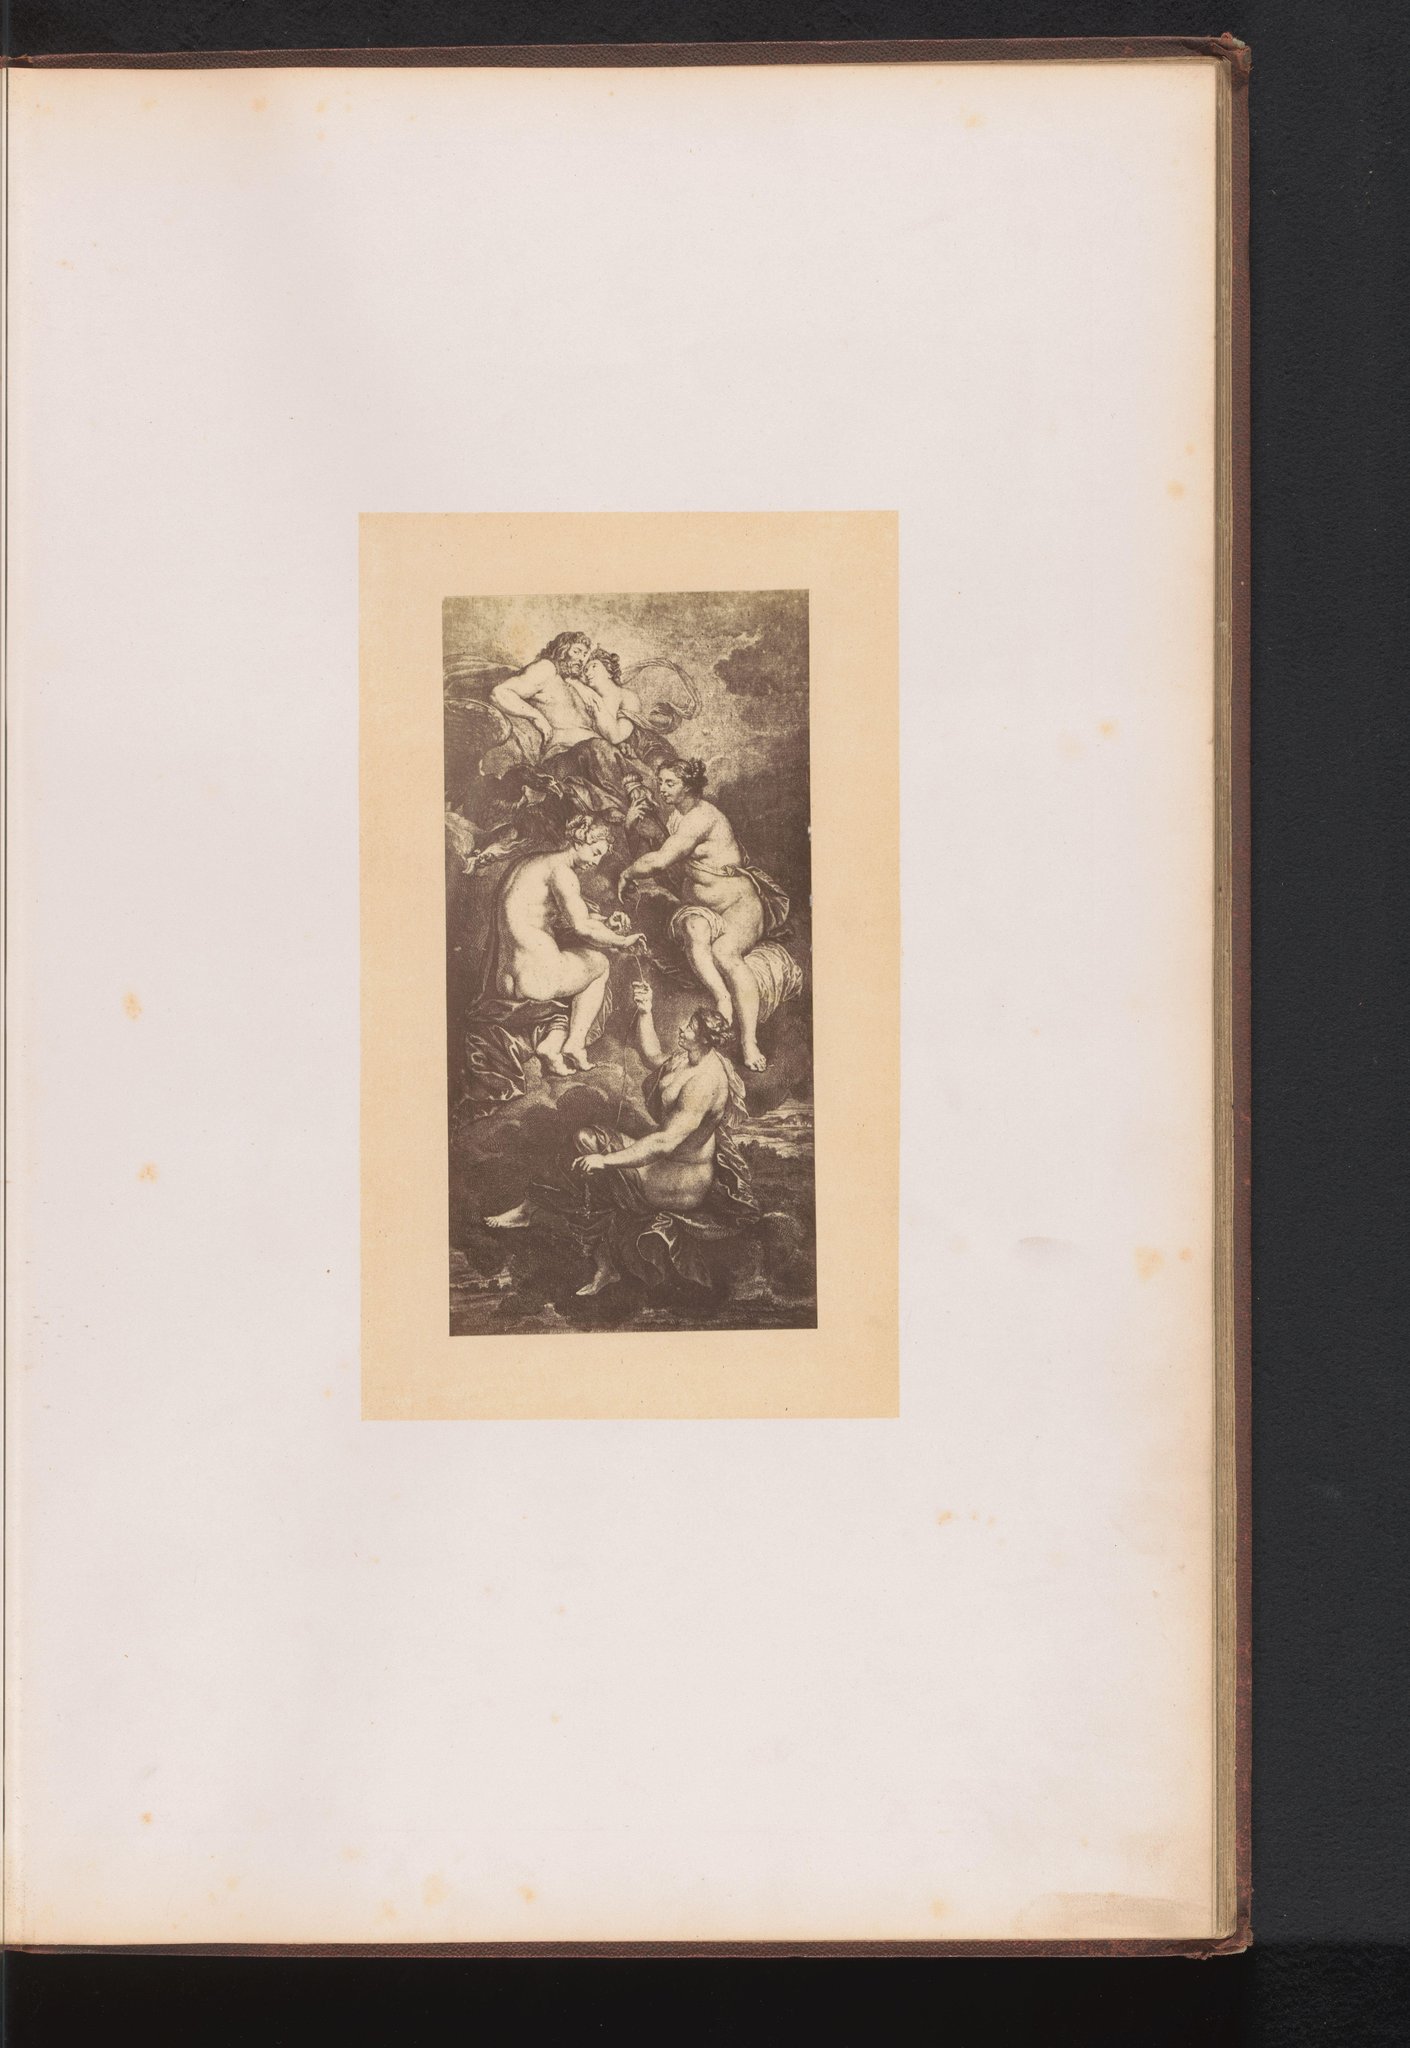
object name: page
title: Fotoreproductie van een gravure van De lotsbestemming van Maria de'Medici door Jean-Marc Nattier, naar het schilderij door Peter Paul Rubens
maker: peter paul rubens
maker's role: draughtsman, painter, print maker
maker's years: 1577-1640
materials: photographic support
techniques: albumen print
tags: cologne, print maker, maria de' medici, couple of lovers